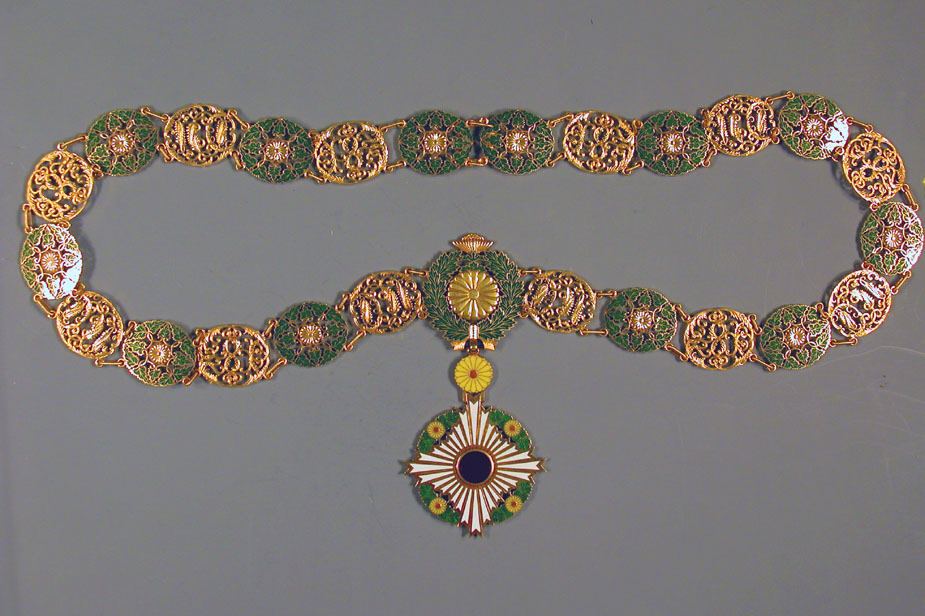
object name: collar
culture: japanese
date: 1867-1900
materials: metal